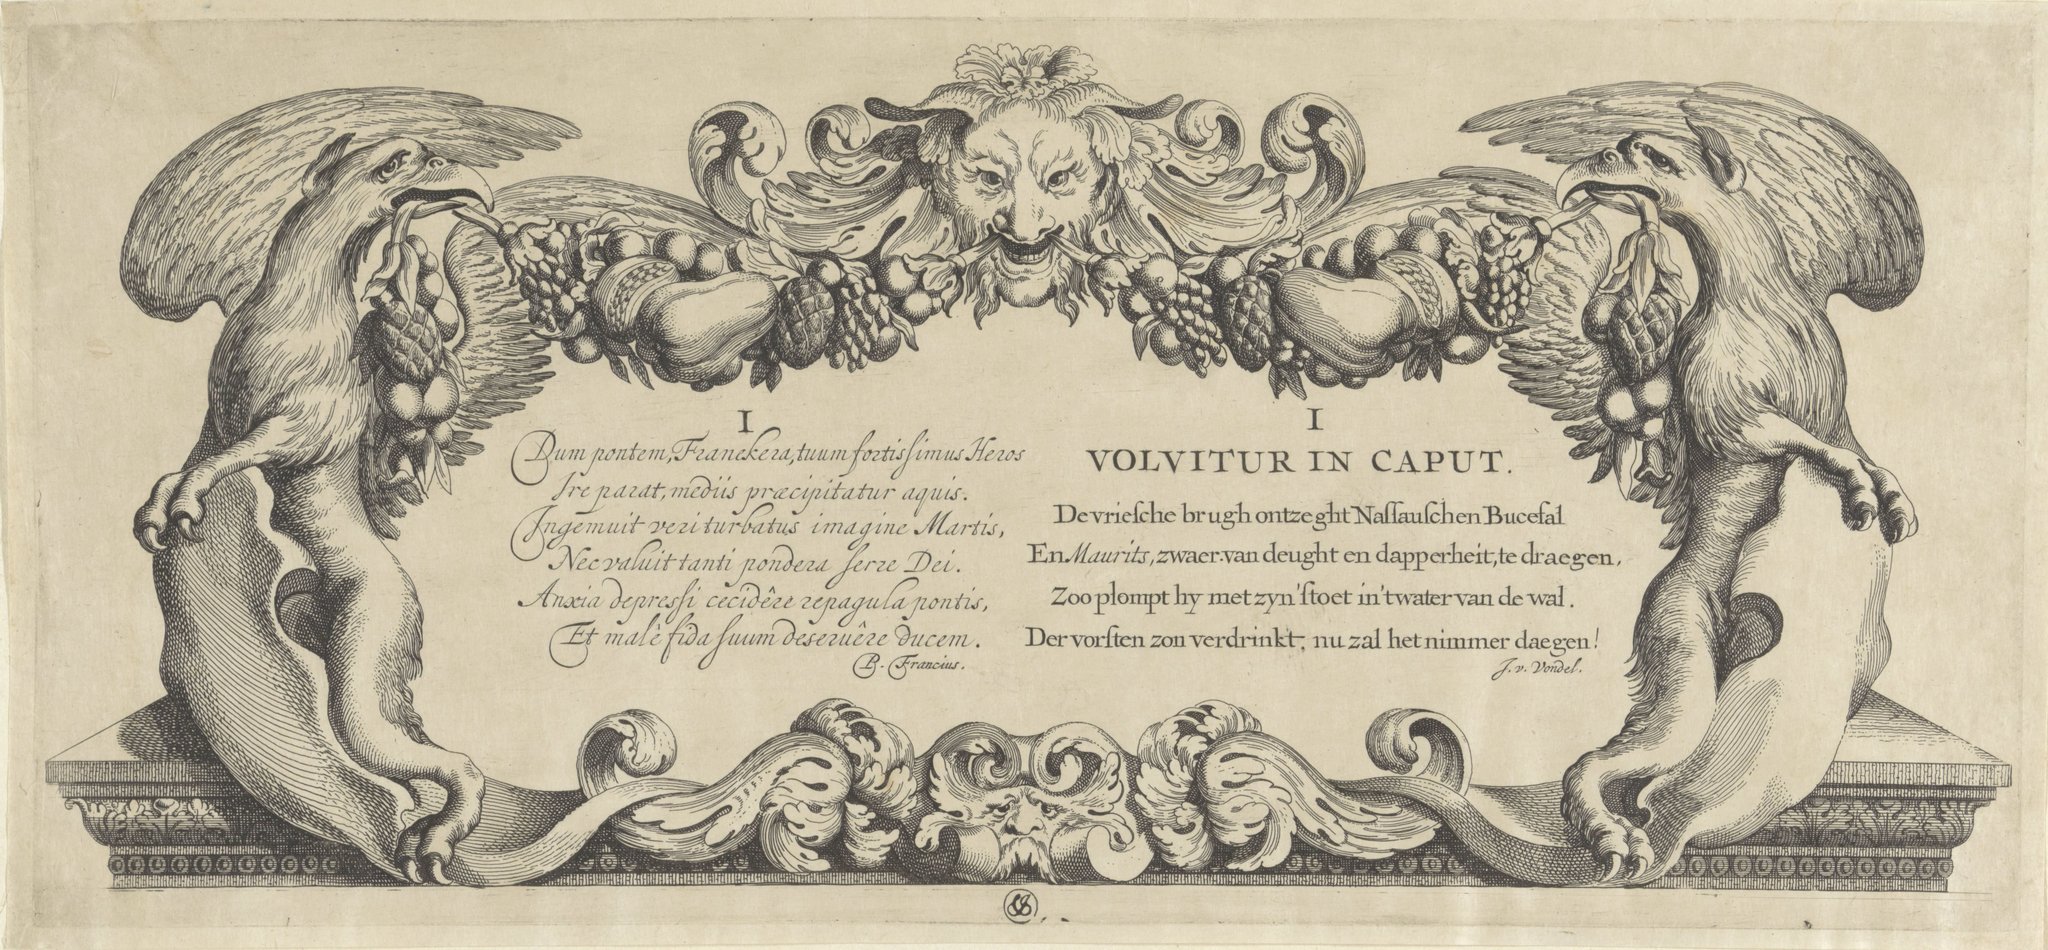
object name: print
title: Teksten bij de voorstelling van het ongeluk van graaf Johan Maurits op de brug van Franeker, 1665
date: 1665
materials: paper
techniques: etching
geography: northern netherlands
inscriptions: collector's mark: Lugt 12, collector's mark: Lugt 2165, collector's mark: Lugt 573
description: Blad met een cartouche met twee teksten behorend bij de eerste plaat met de voorstelling van het ongeluk van graaf Johan Maurits op de brug van Franeker, 6 januari 1665. Cartouche gevormd door een festoen van vruchten vastgehouden door twee griffioenen. Links een vers van zes regels in het Latijn, rechts een vers van 4 regels in het Nederlands.